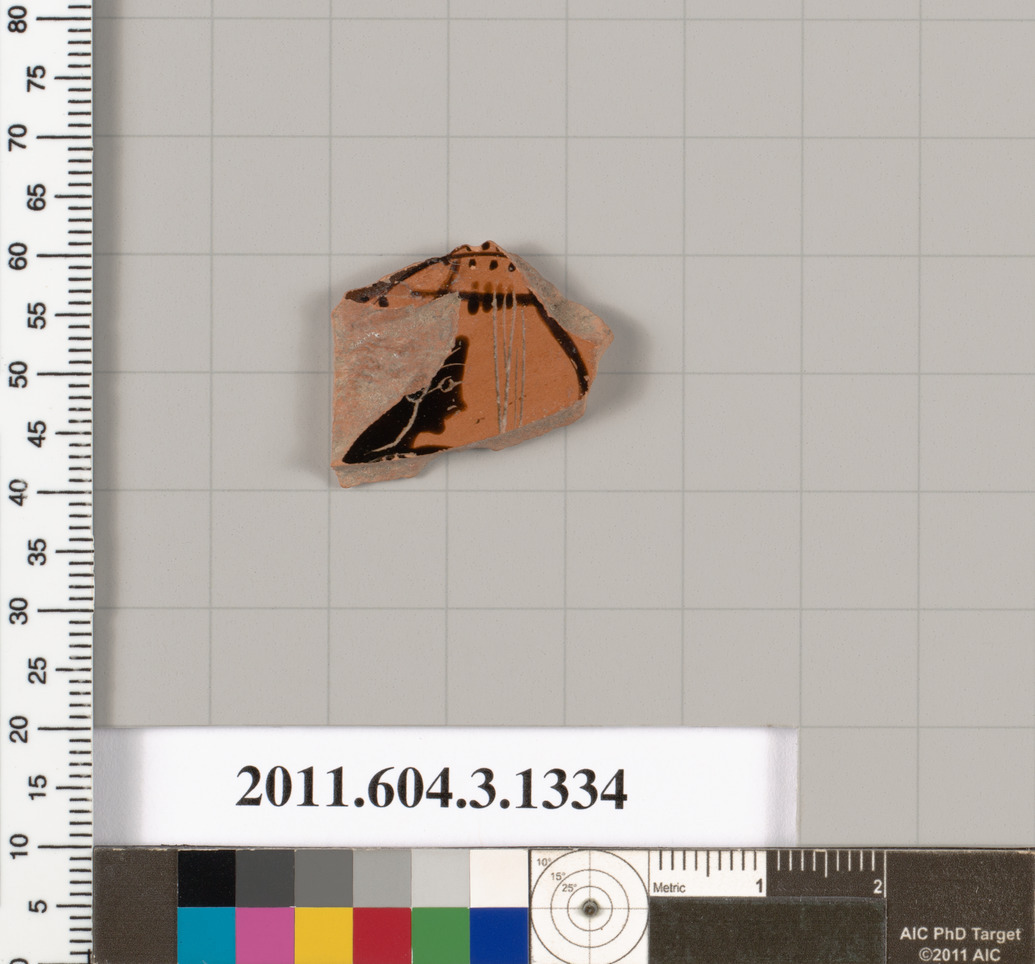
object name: skyphos fragment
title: Terracotta fragment of a skyphos (deep drinking cup)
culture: greek, attic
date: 500-468 BCE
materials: terracotta